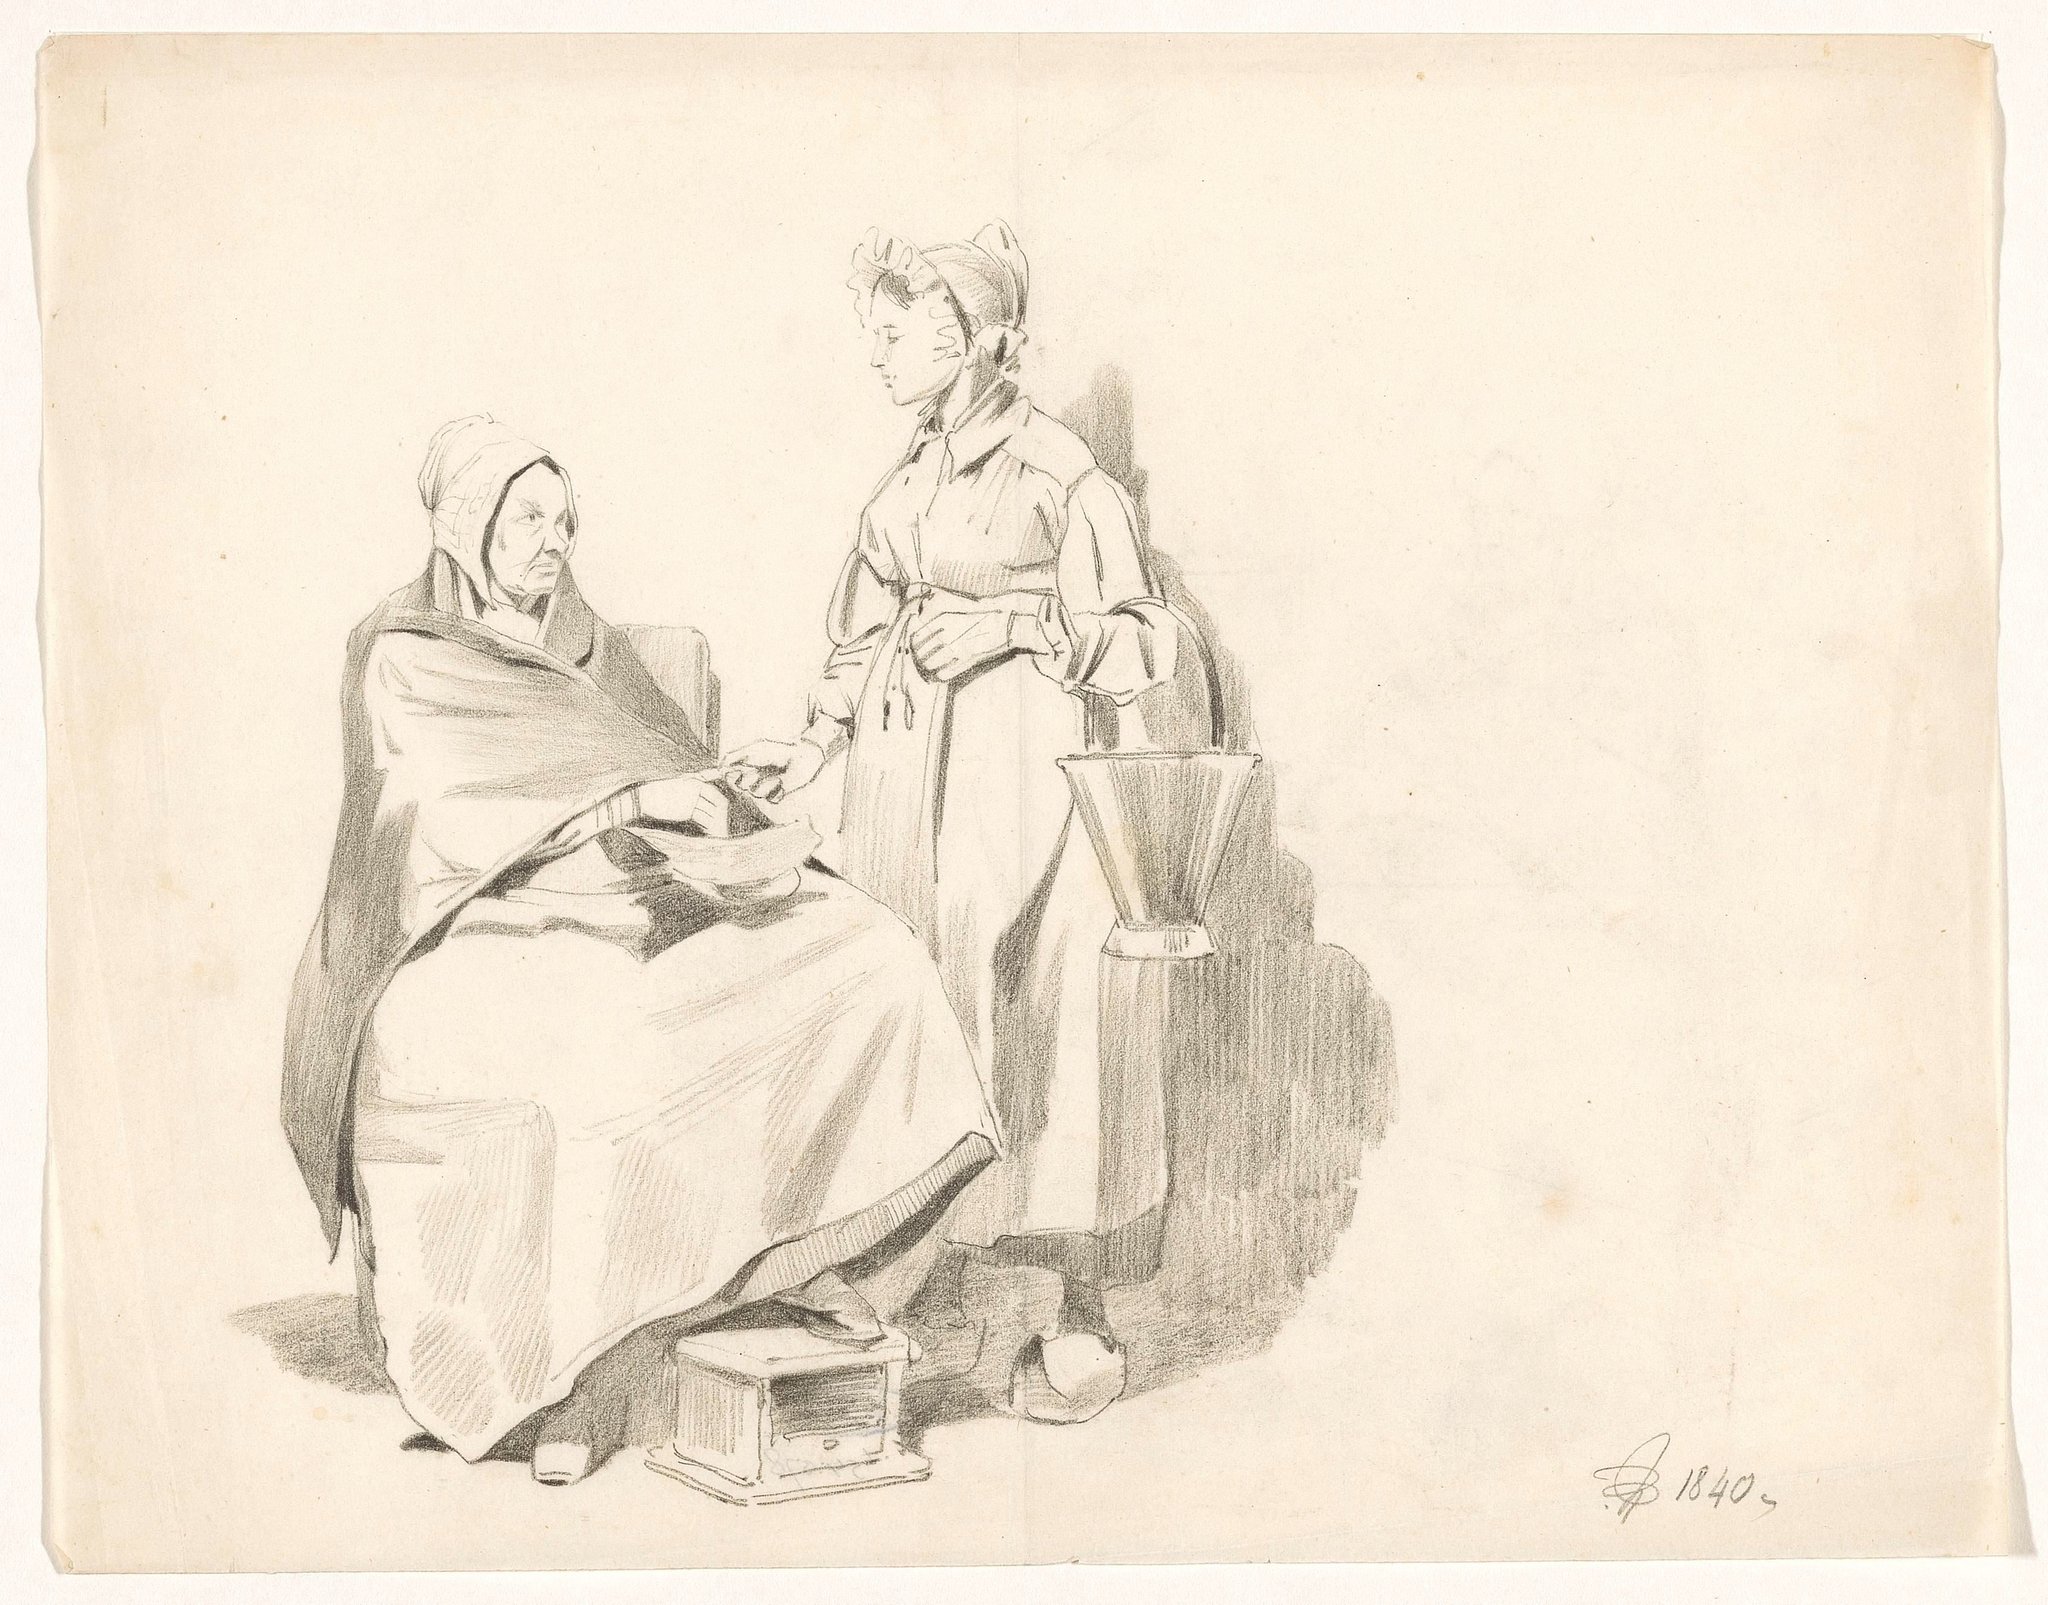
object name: drawing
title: Staande jonge vrouw bij zittende oude vrouw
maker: pieter van loon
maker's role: draughtsman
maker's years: 1801-1873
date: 1840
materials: paper, pencil